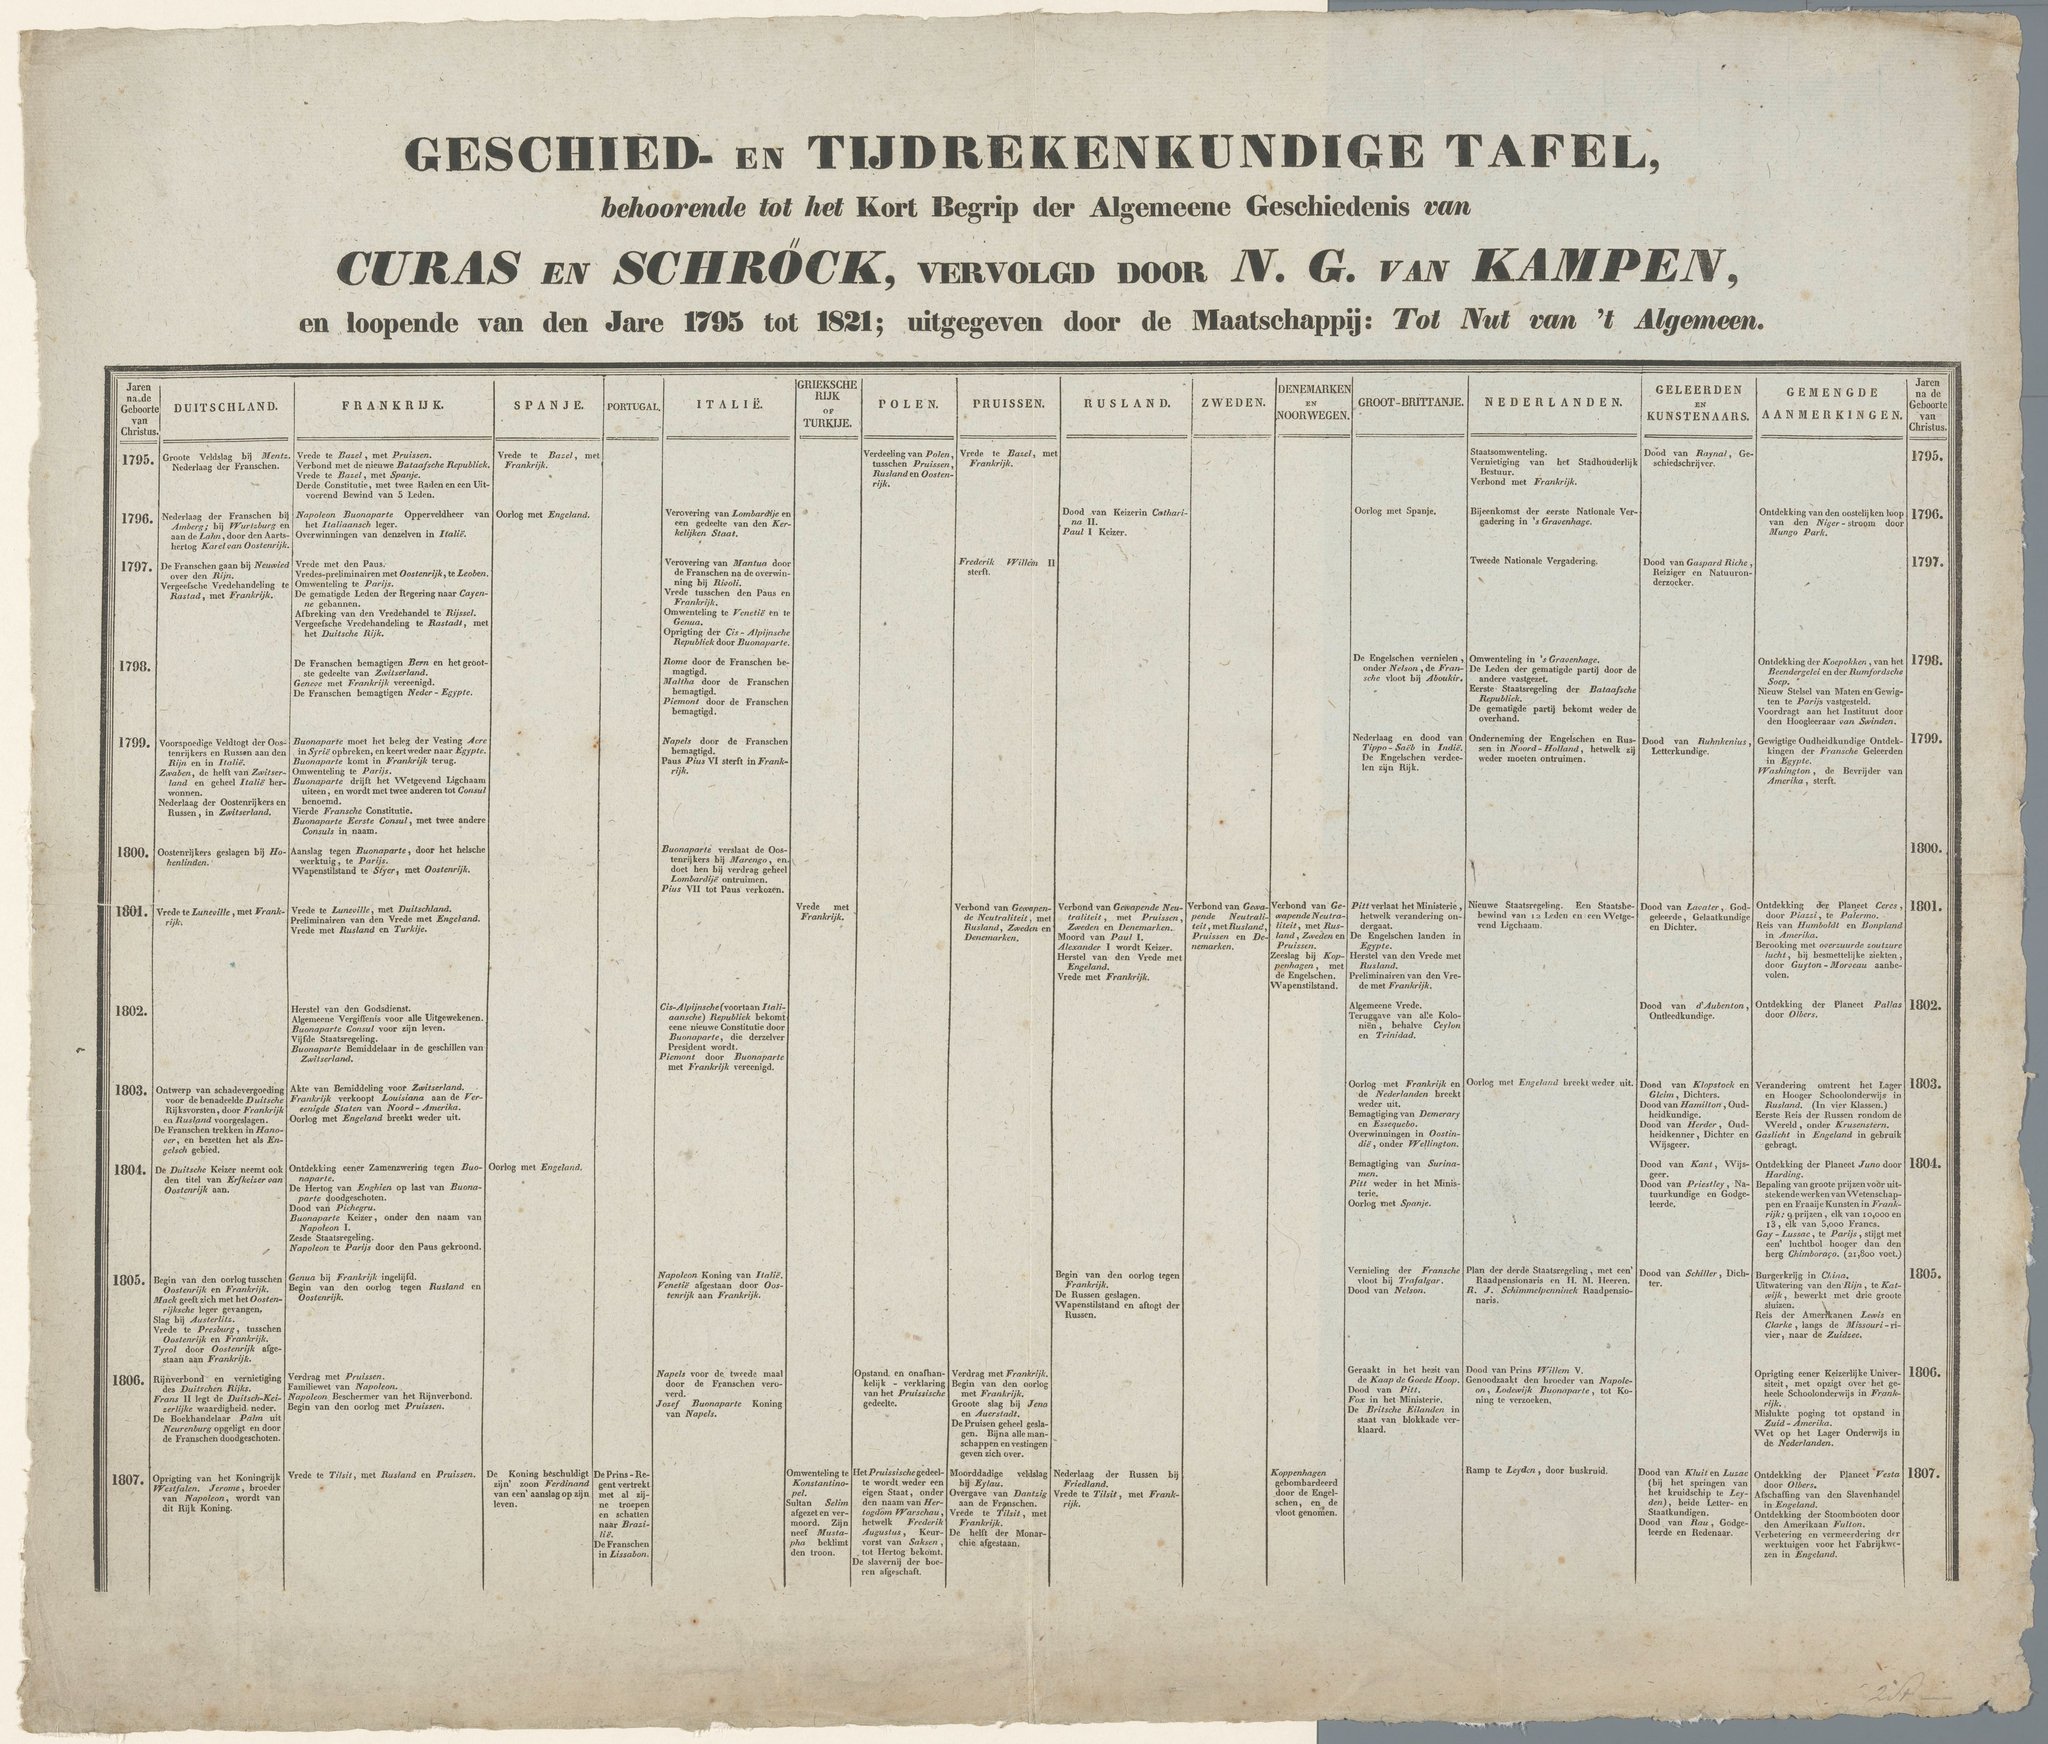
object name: text sheet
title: Geschied- en Tijdrekenkundige Tafel, behoorende tot het Kort Begrip der Algemeene Geschiedenis van Curas en Schröck, vervolgd door N.G. van Kampen, en loopende van den Jare 1795 tot 1821; uitgegeven door de Maatschappij: Tot Nut van t'Algemeen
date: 1827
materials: paper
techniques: letterpress printing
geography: groningen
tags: surrender ~ war, historical events and situations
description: Tabel met een overzicht van de historische gebeurtenissen in Europa tussen 1795 en 1821. Bovenste van twee delen. Uitgegeven in 1827.